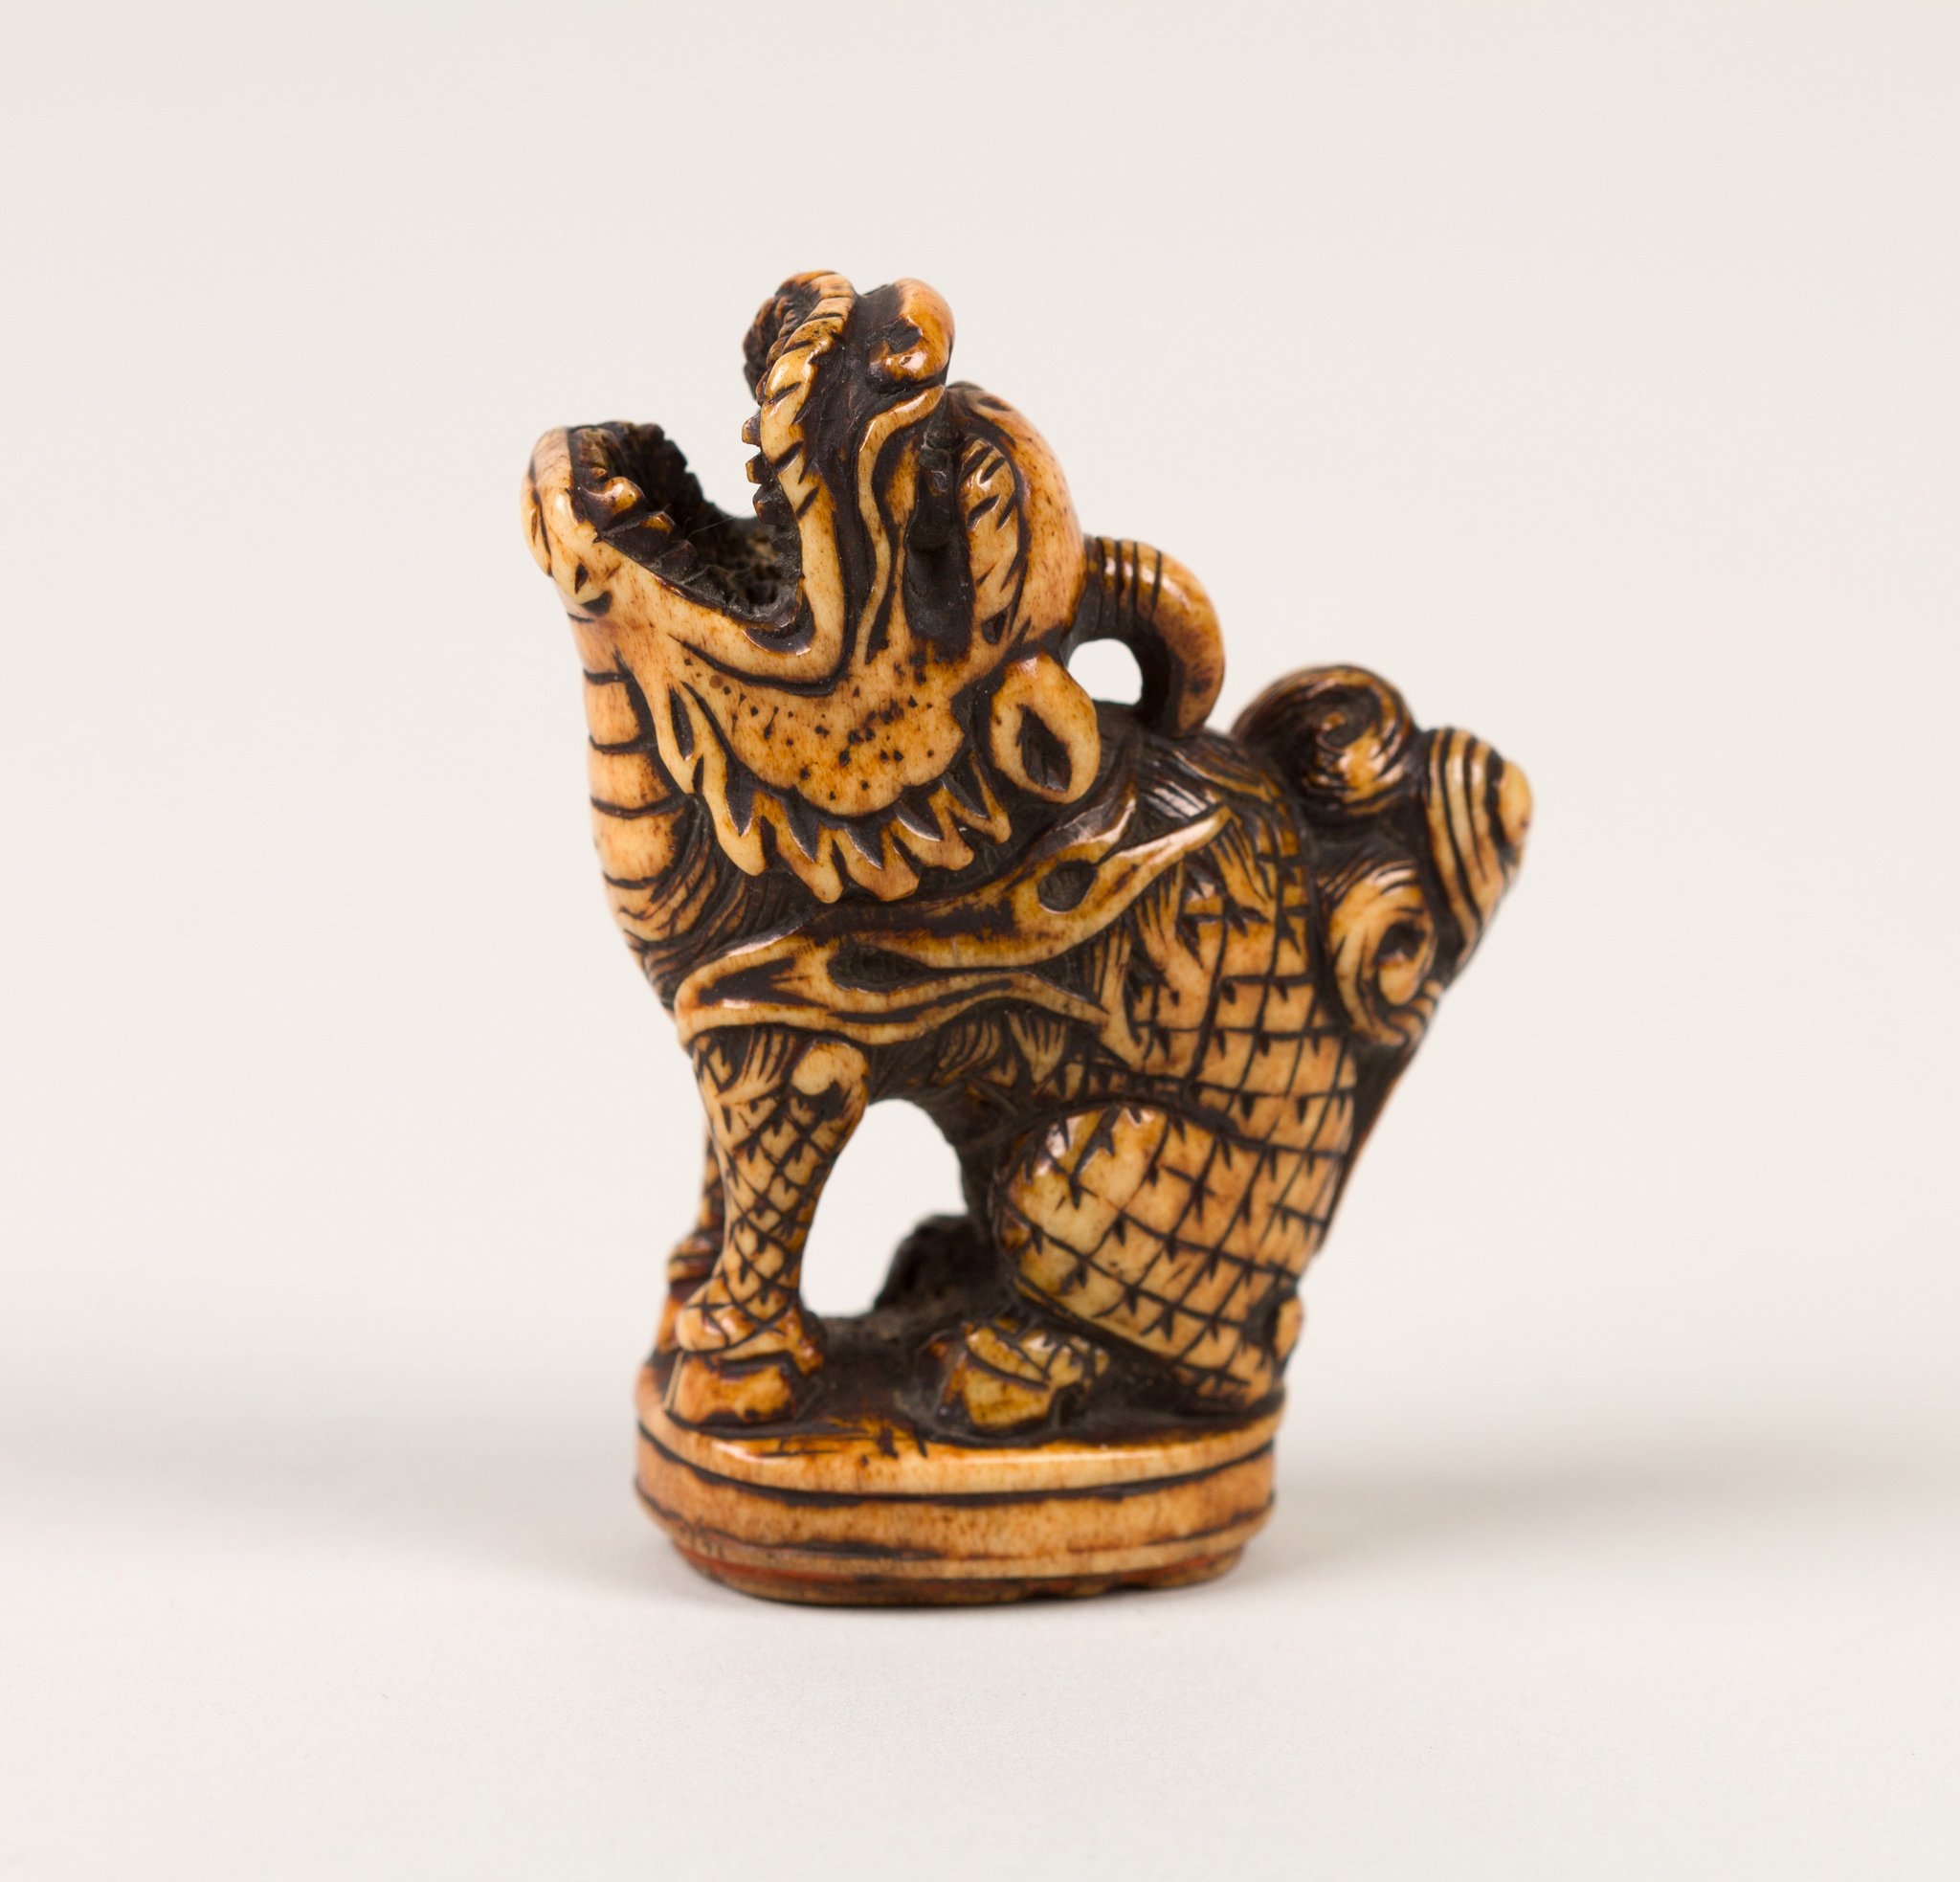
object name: netsuke and seal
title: Netsuke and Seal in form of a Qilin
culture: japanese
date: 1801-1900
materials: ivory